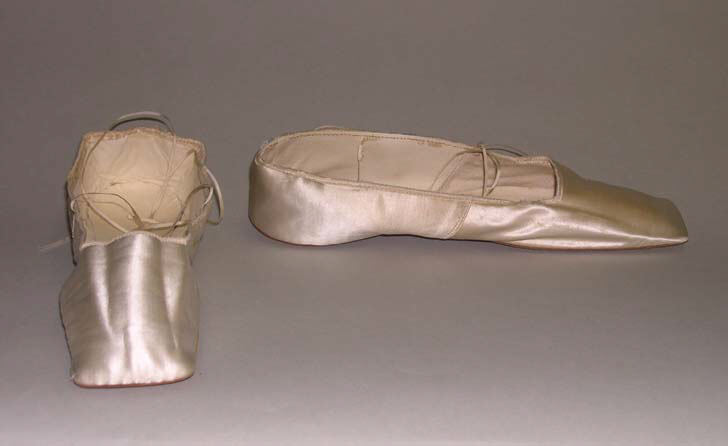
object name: slipper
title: Slippers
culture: american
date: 1830-1850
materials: silk